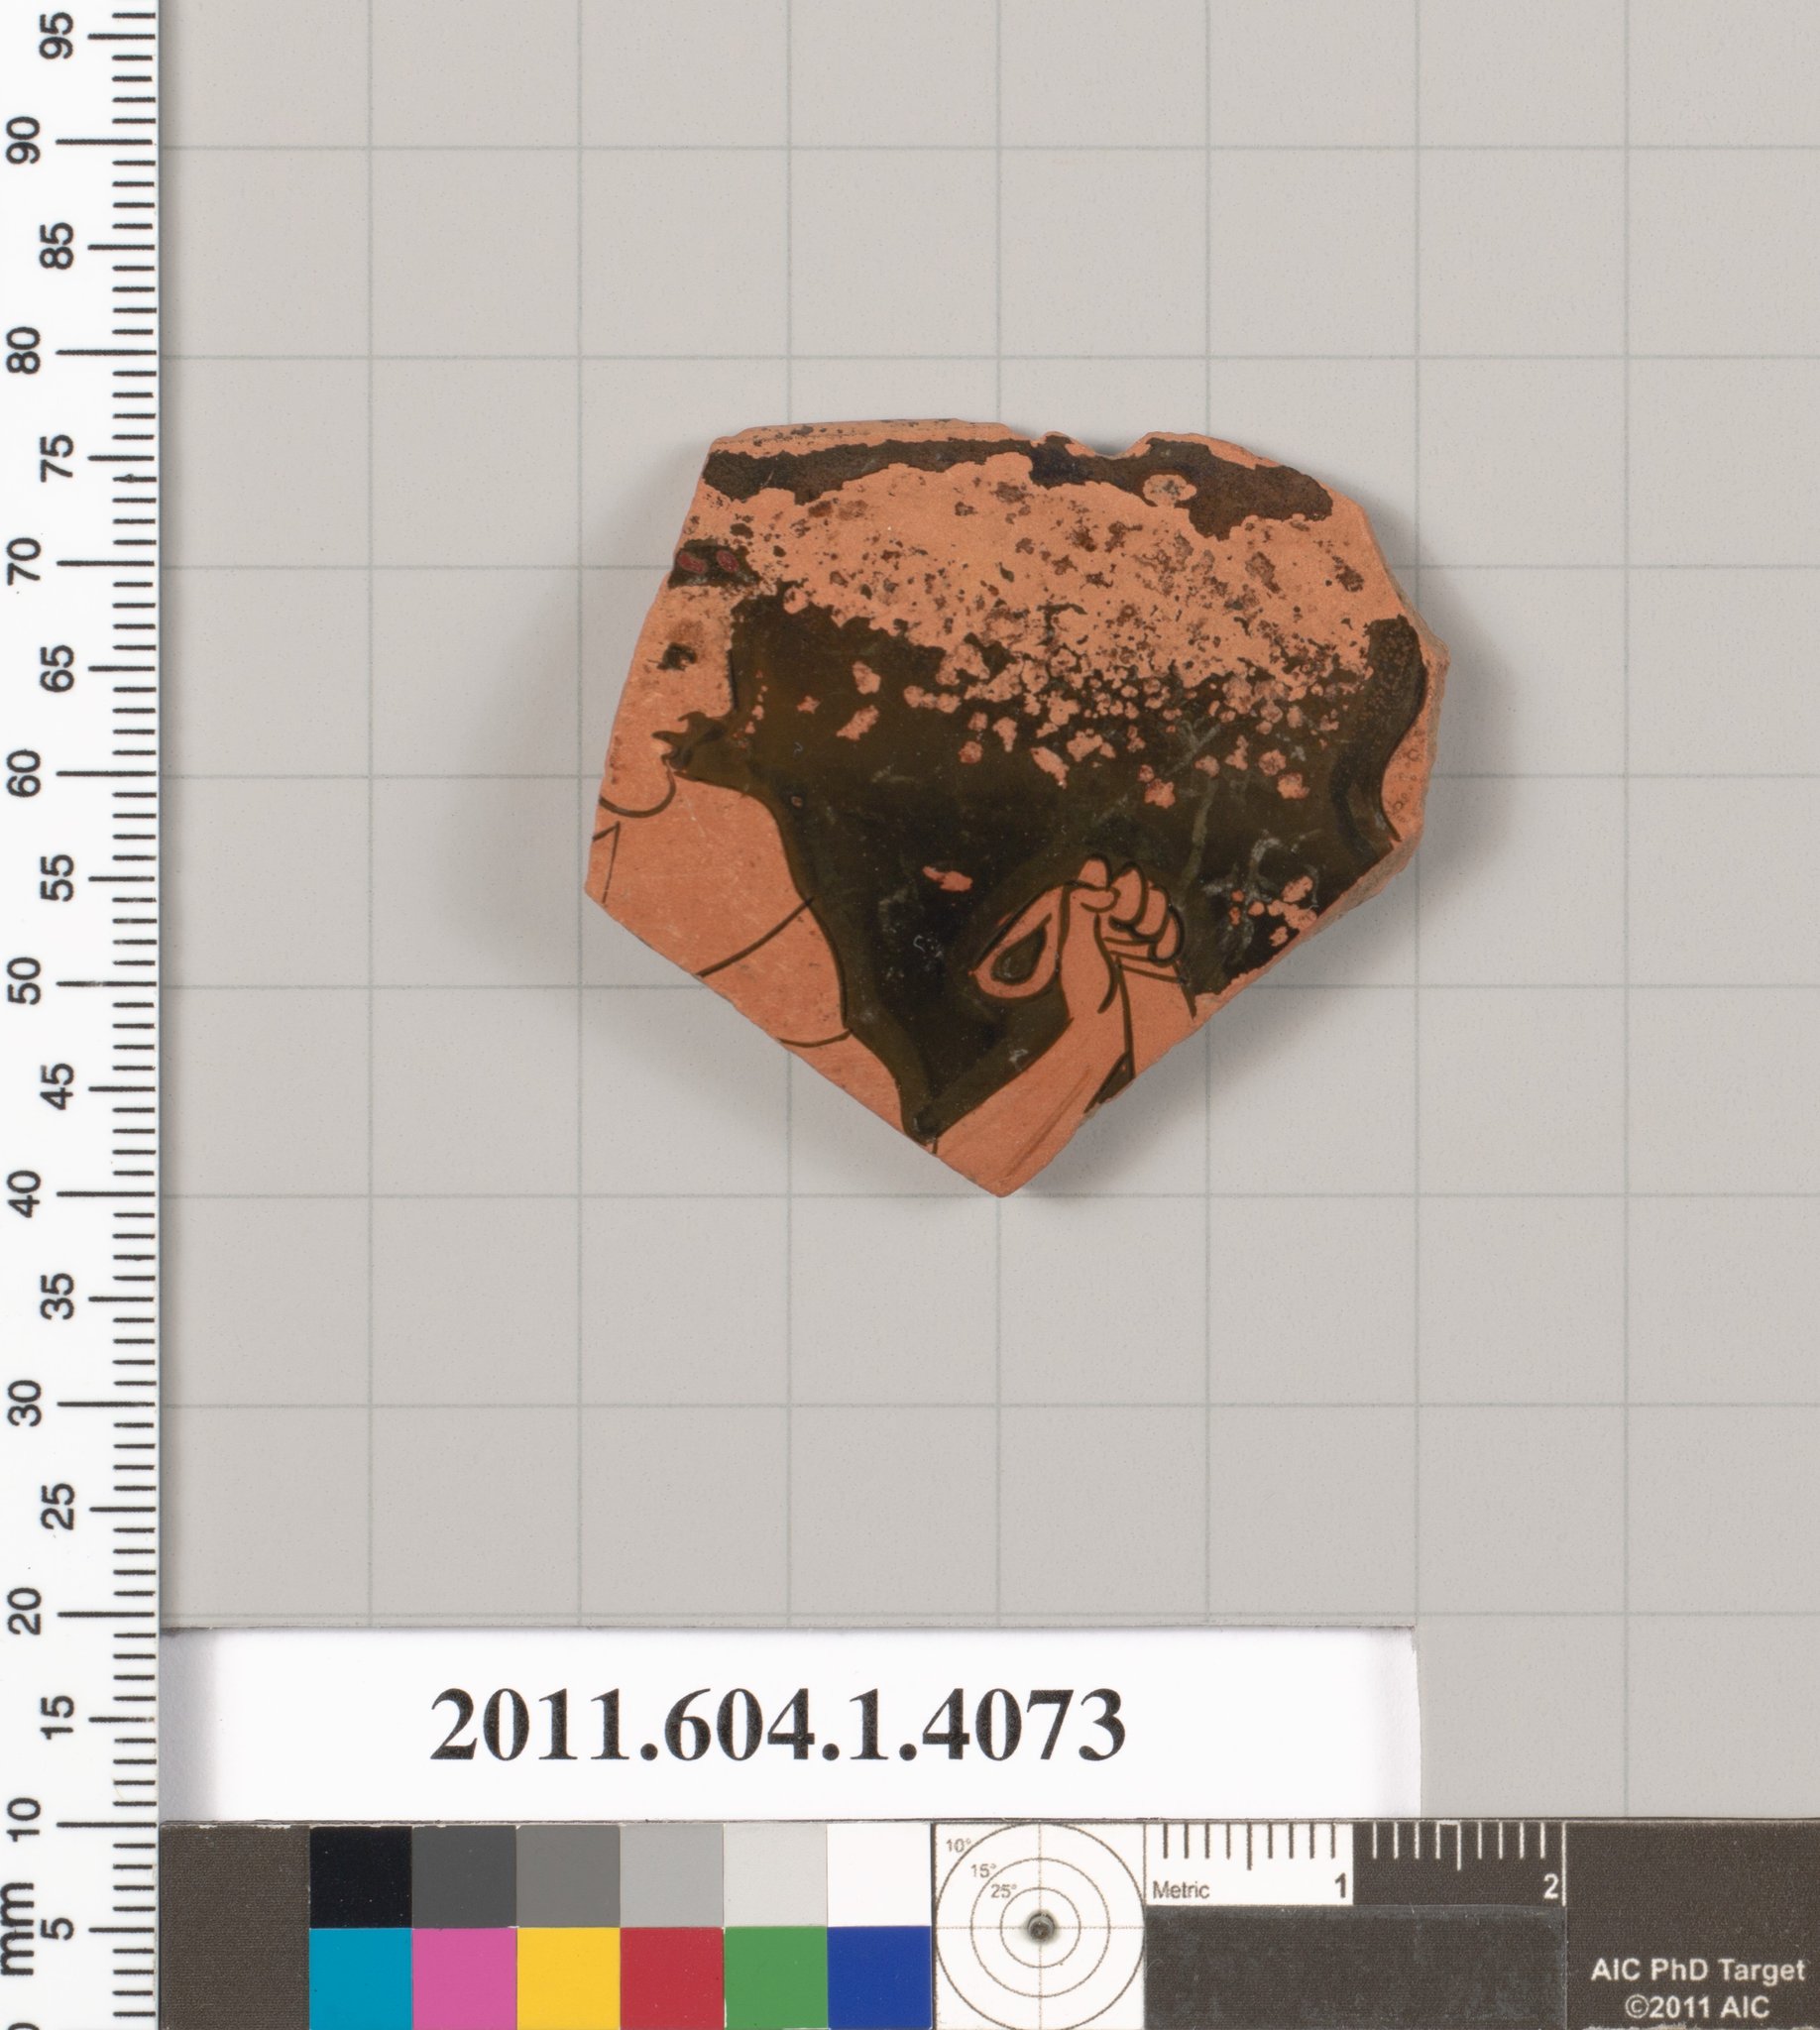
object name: kylix fragment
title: Terracotta rim fragment of a kylix (drinking cup)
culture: greek, attic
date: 490-470 BCE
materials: terracotta